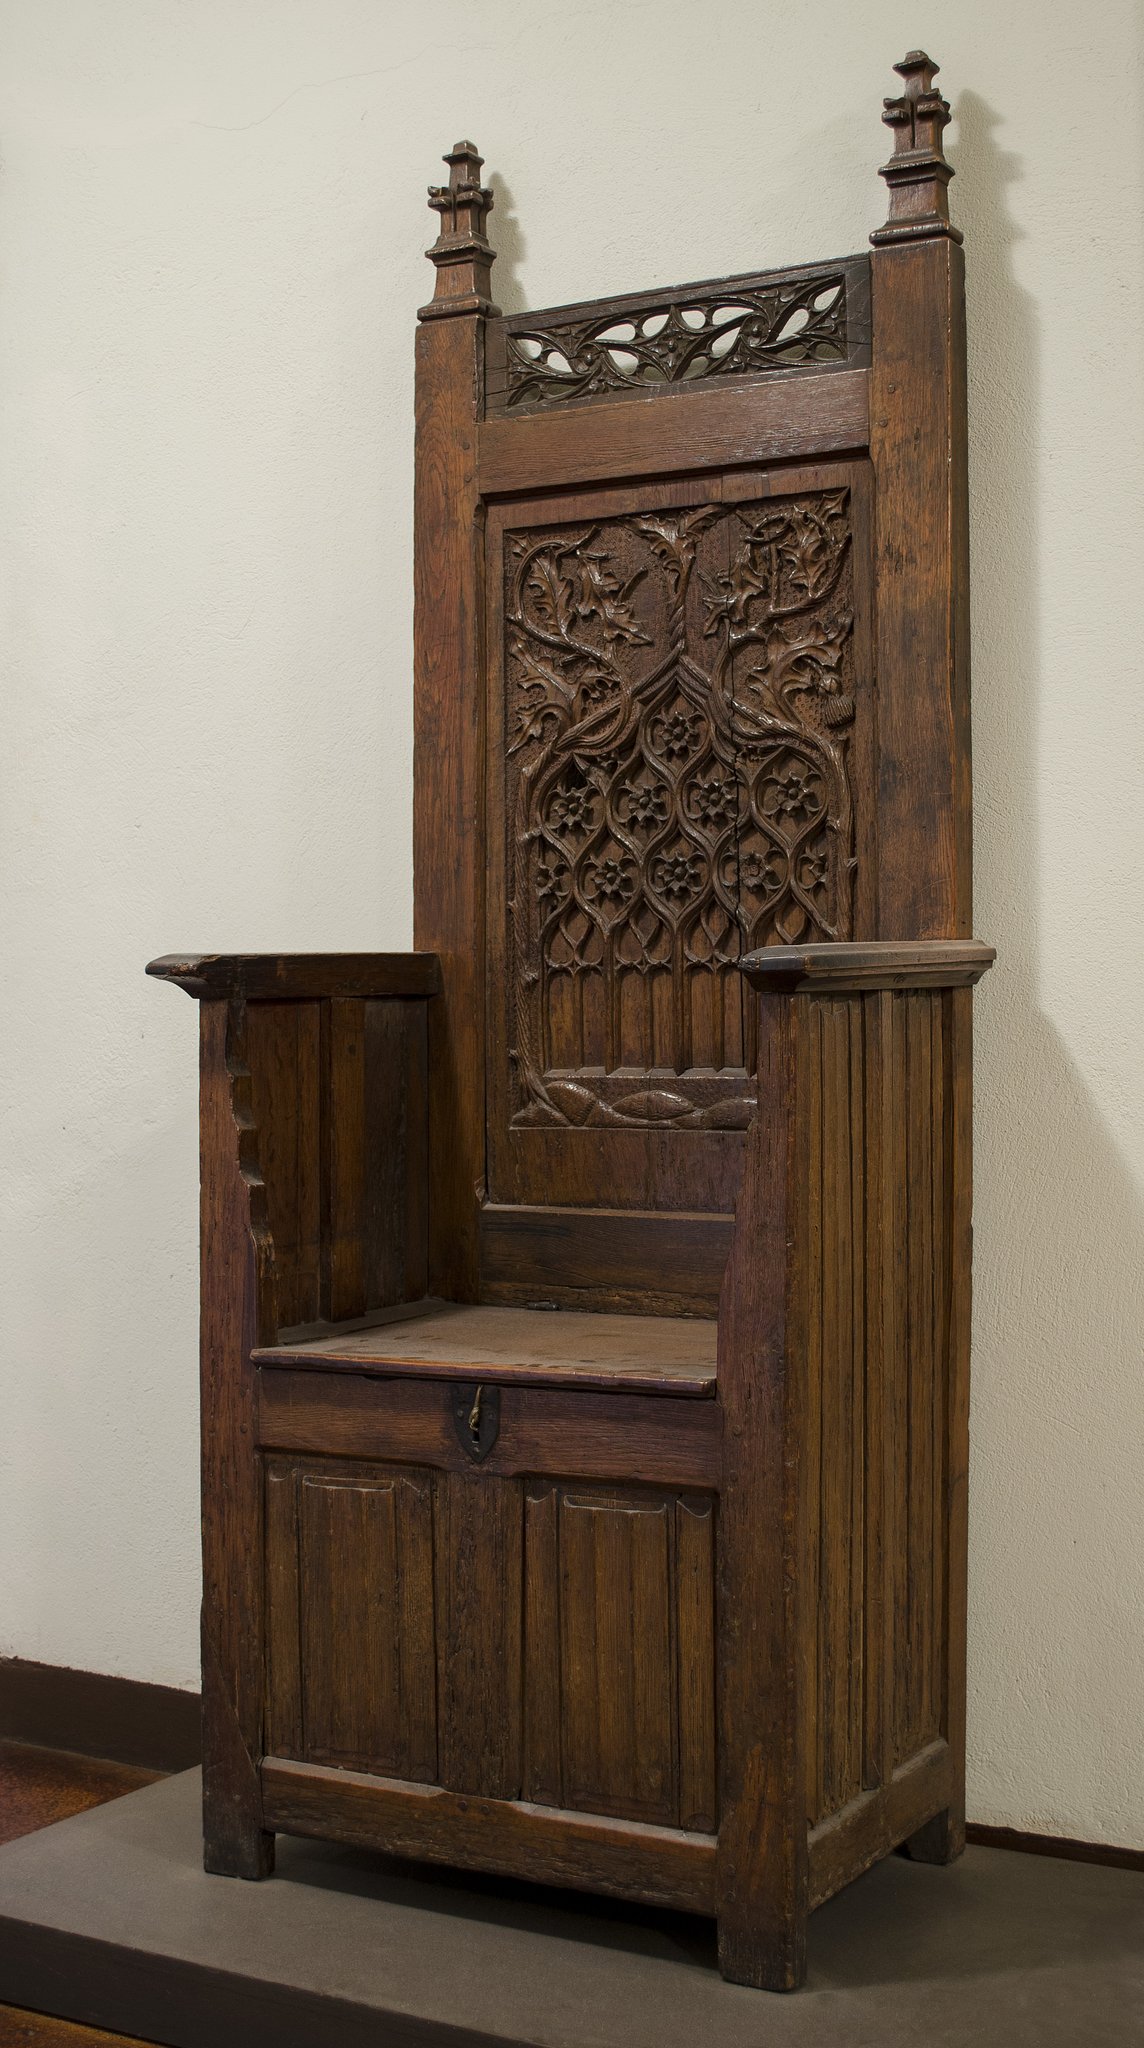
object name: chair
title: High-Backed Chair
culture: french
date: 1401-1600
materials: wood